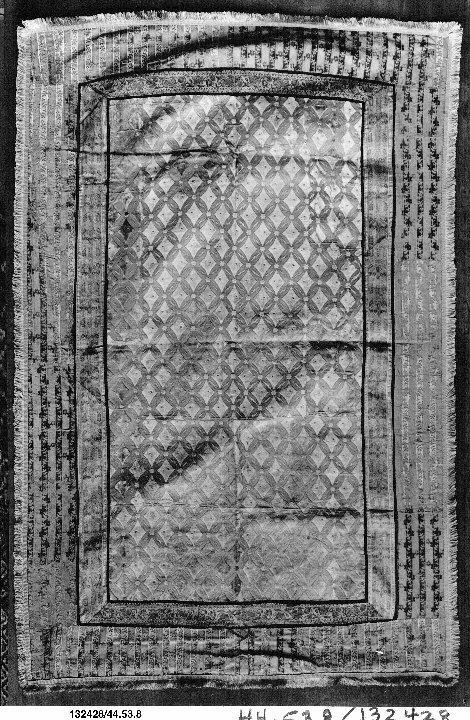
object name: cover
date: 1701-1800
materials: silk, velvet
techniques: brocade, cutting, voiding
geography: iran